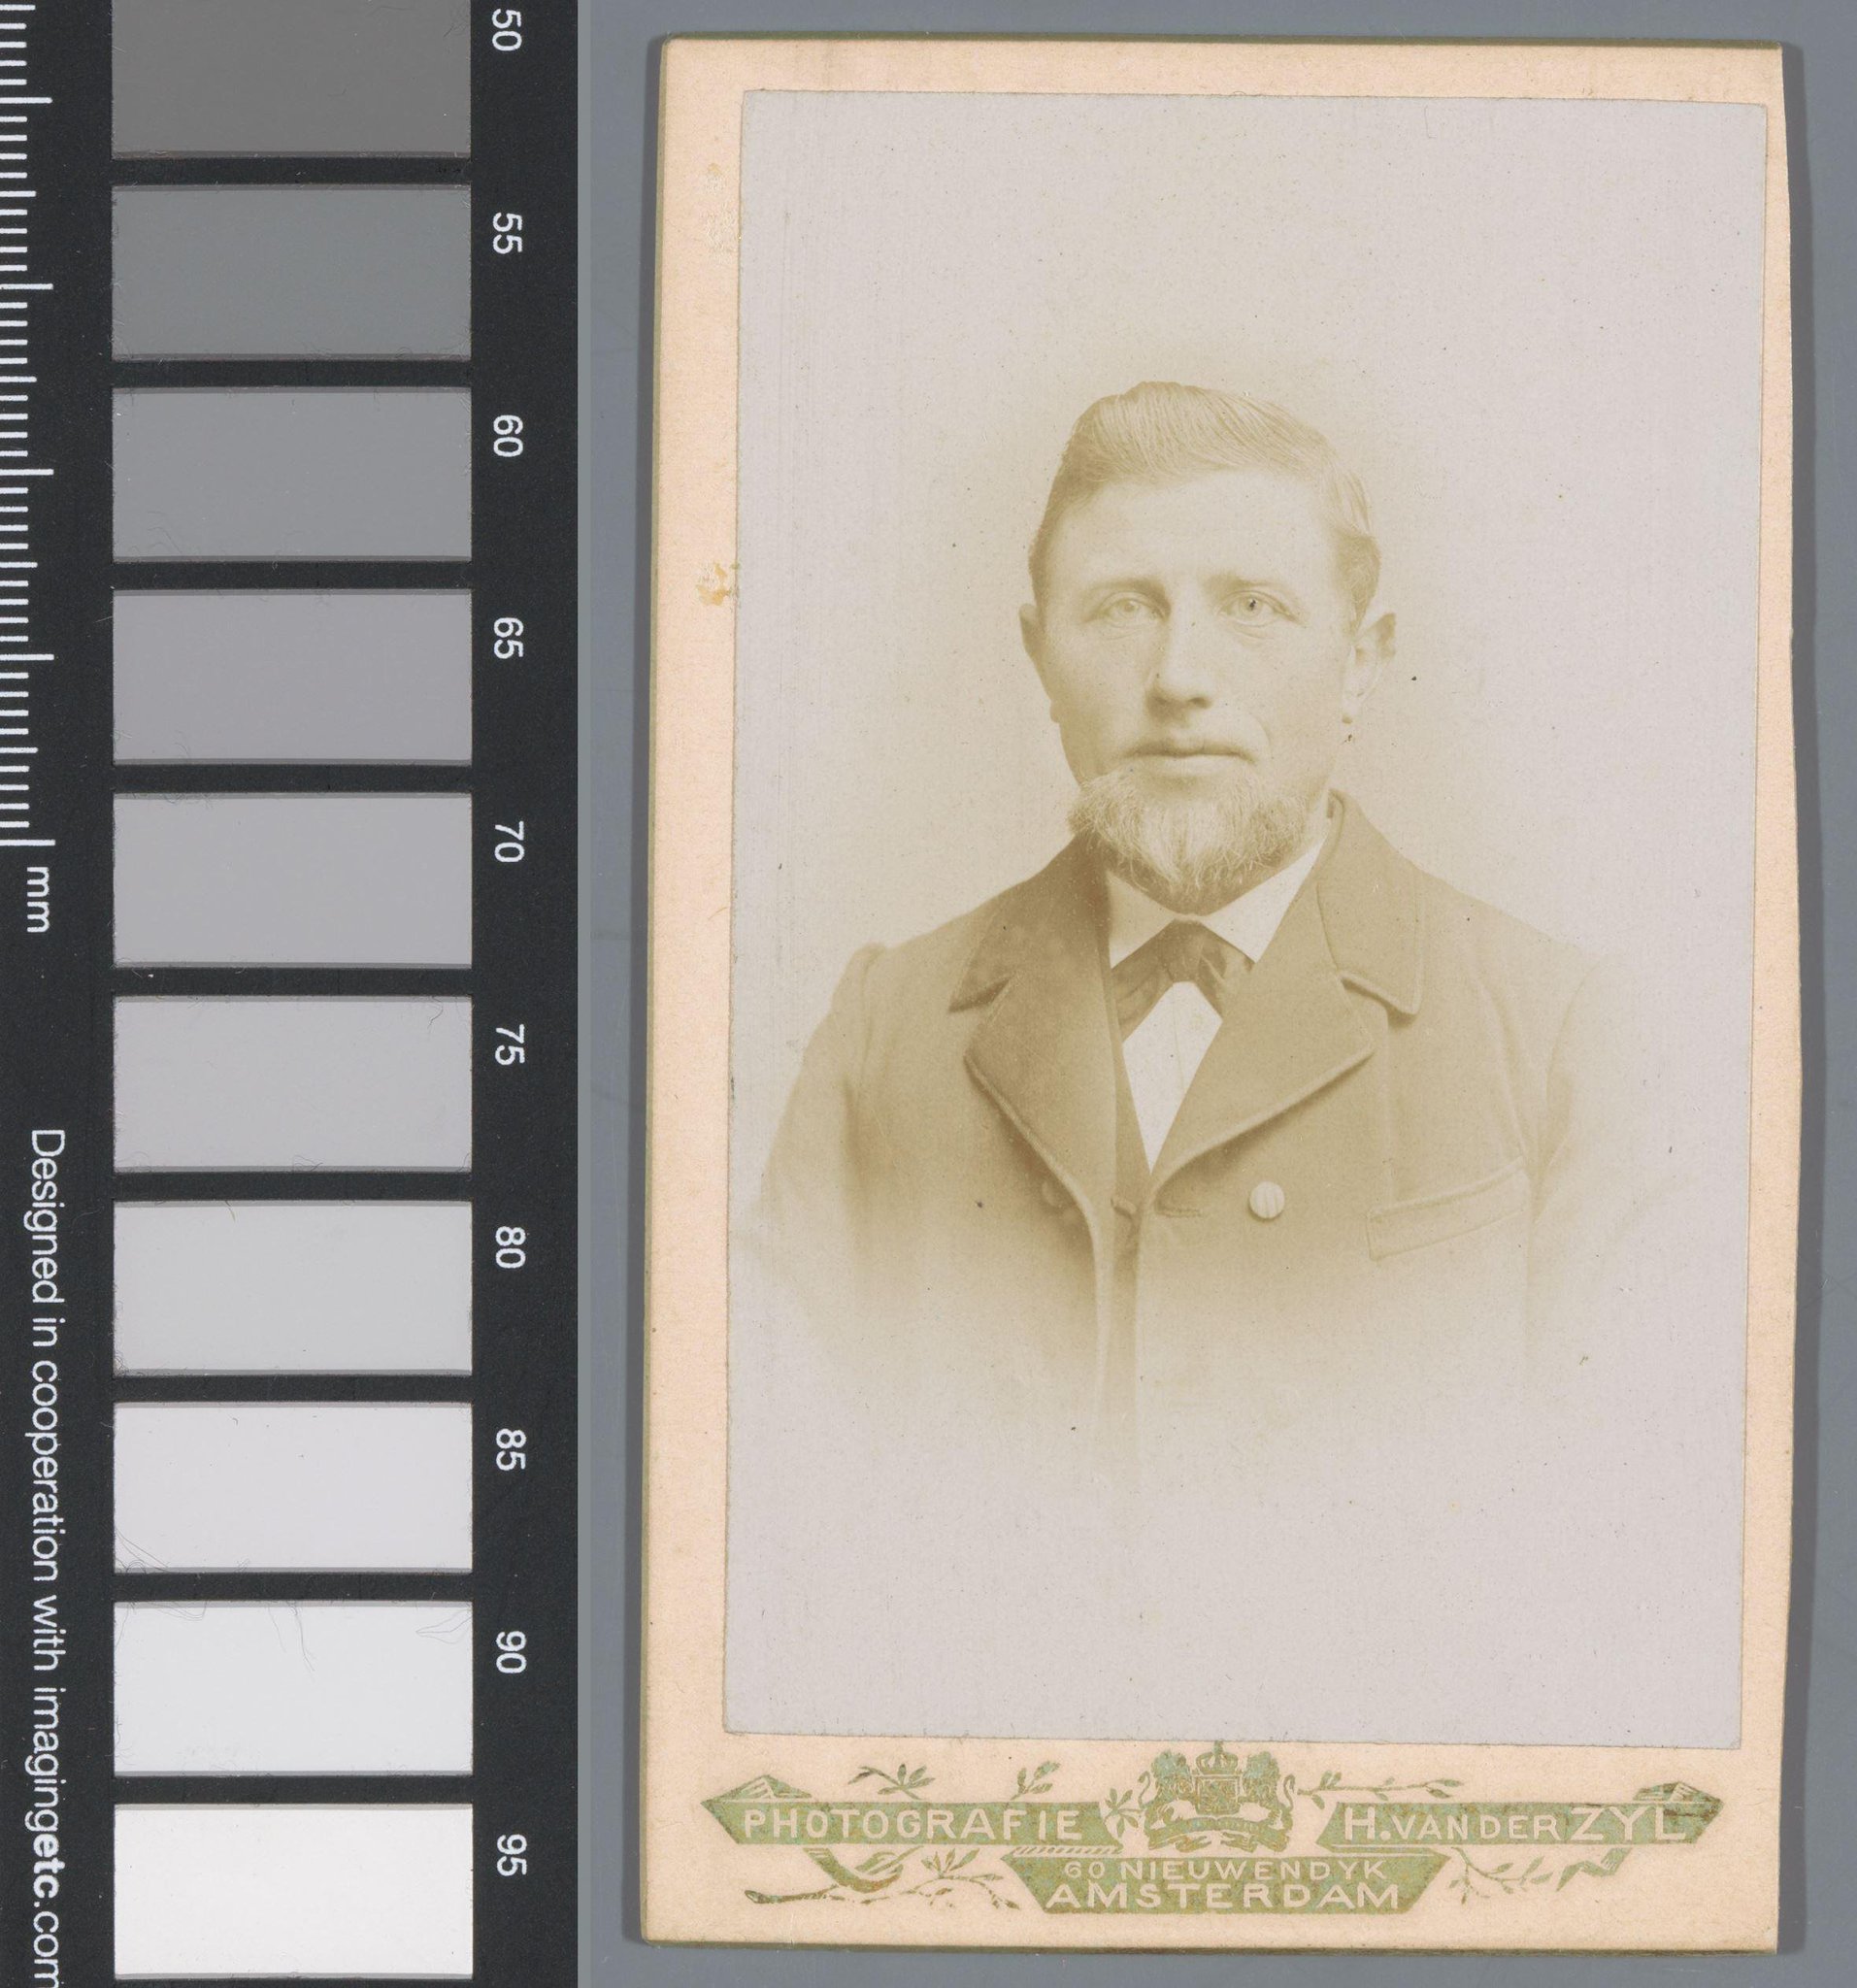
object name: photograph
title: Portret van Cornelis Visser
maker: h. van der zijl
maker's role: fotograaf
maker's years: 1852-1937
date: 1886-1908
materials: cardboard, photographic support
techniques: gelatin silver print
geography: amsterdam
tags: adult man, historical persons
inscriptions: inscription: ‘Photographie/ Parisienne/ H. van der Zijl/ AMSTERDAM/ 60 NIEUWENDIJK 60/ over Raamskooi en Kapelsteeg./ GELIEVE OP VOORNAAM H/ EN HUISNUMMER 60 TE LETTEN/ Trapp & Münch, Berlin W.’, inscription: ‘Cornelis Visser van G. B.’